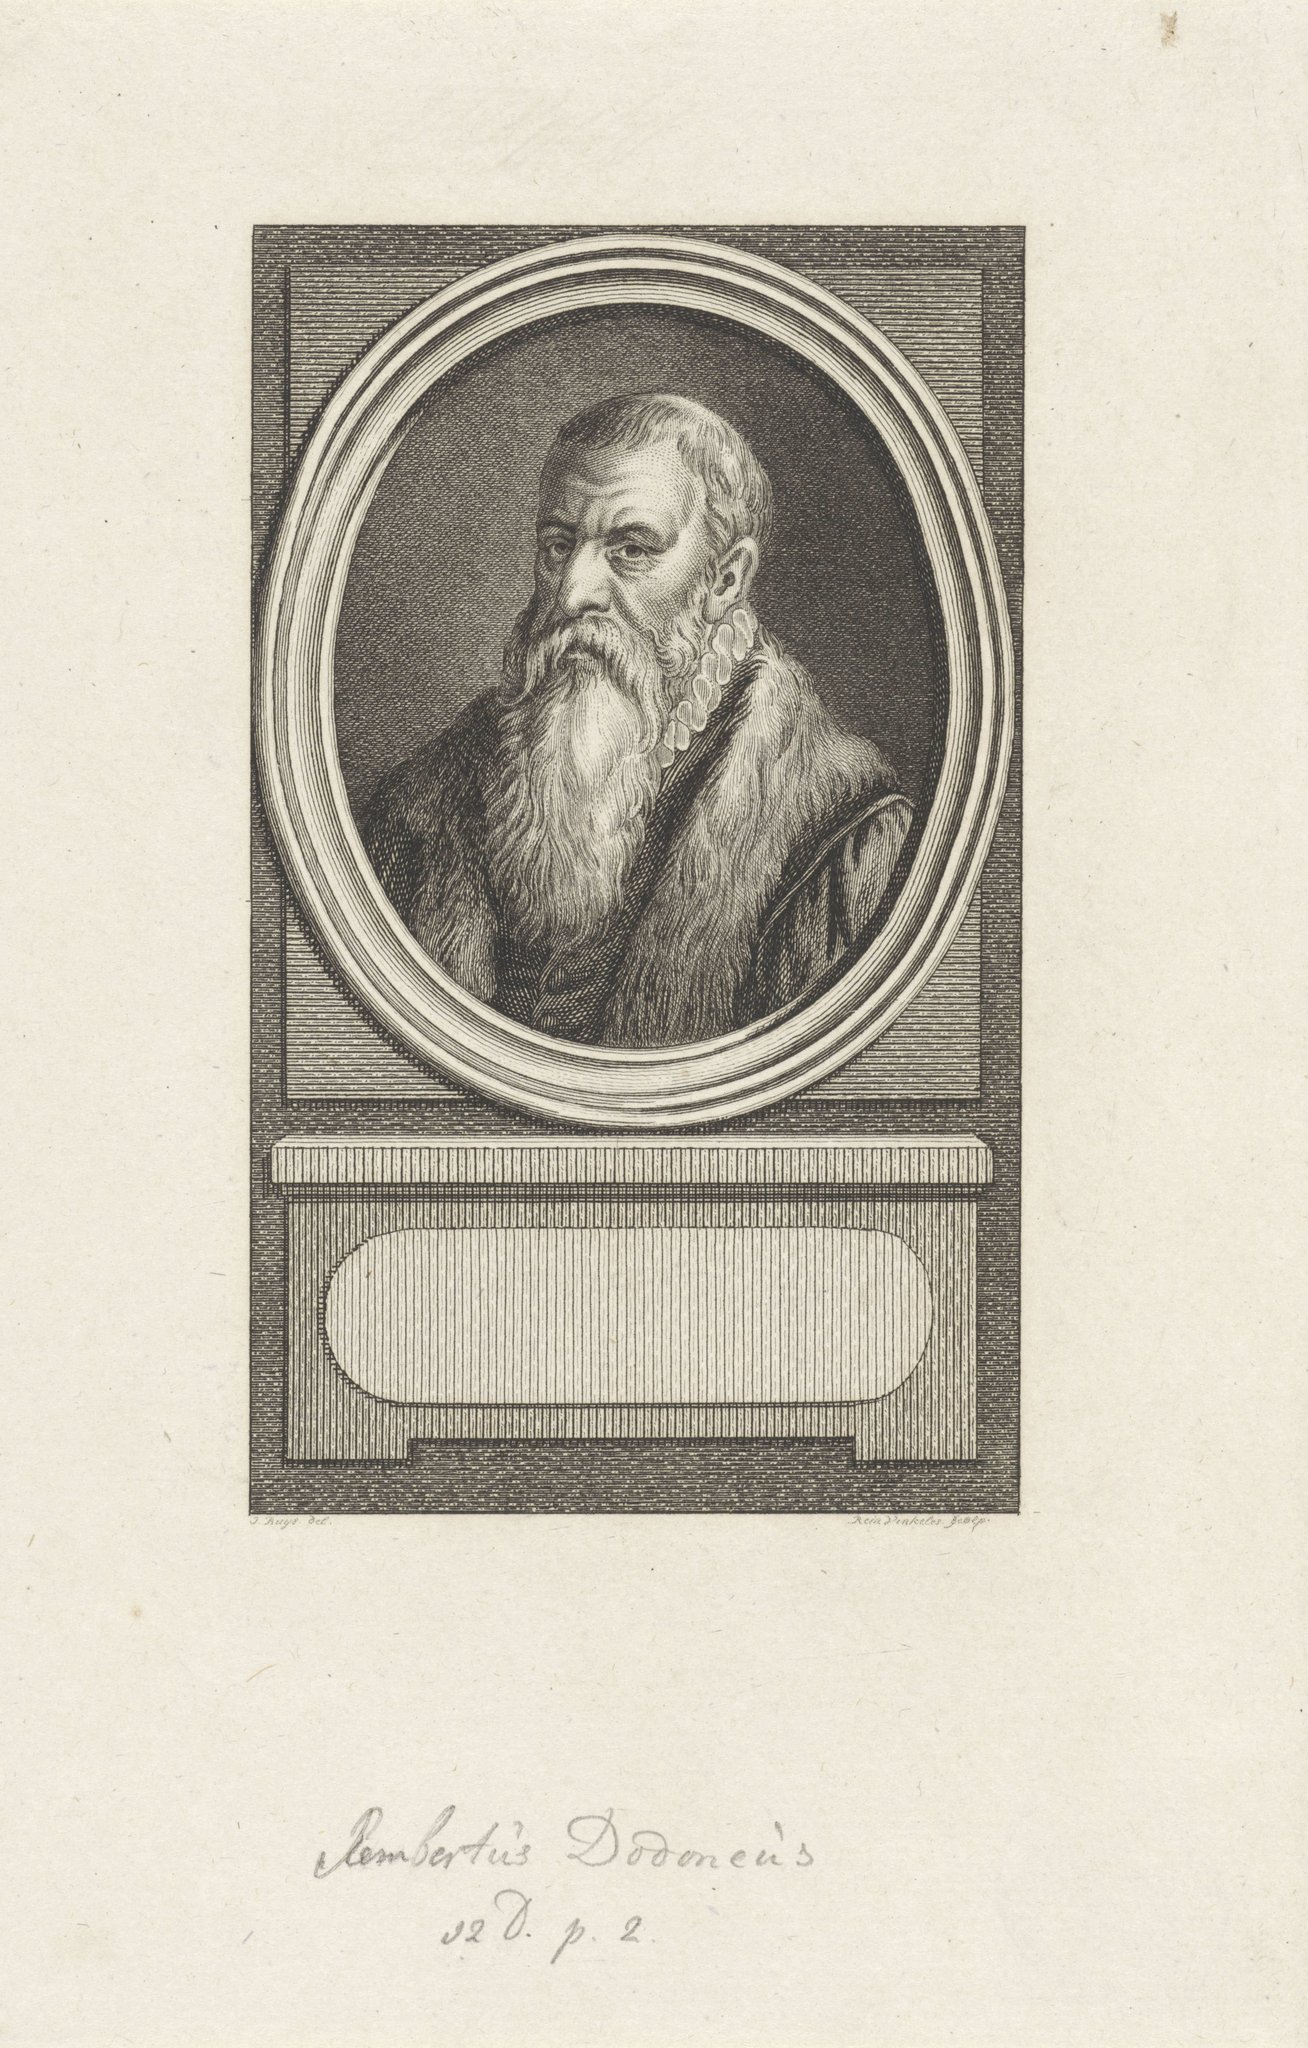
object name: print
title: Portret van de medicus Rembertus Dodonaeus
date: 1789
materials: paper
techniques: etching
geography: amsterdam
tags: mechelen, leiden, rembertus dodonaeus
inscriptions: collector's mark: Lugt 240, inscription: ‘Rembertus Dodoneus 12 d. p. 2.’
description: Latere staat prent gebruikt als boekillustratie in: Kok, Jacobus. Vaderlandsch woordenboek : met kaarten, plaaten en pourtraitten. Amsterdam: Johannes Allart, 1785-1796. Deel XII.